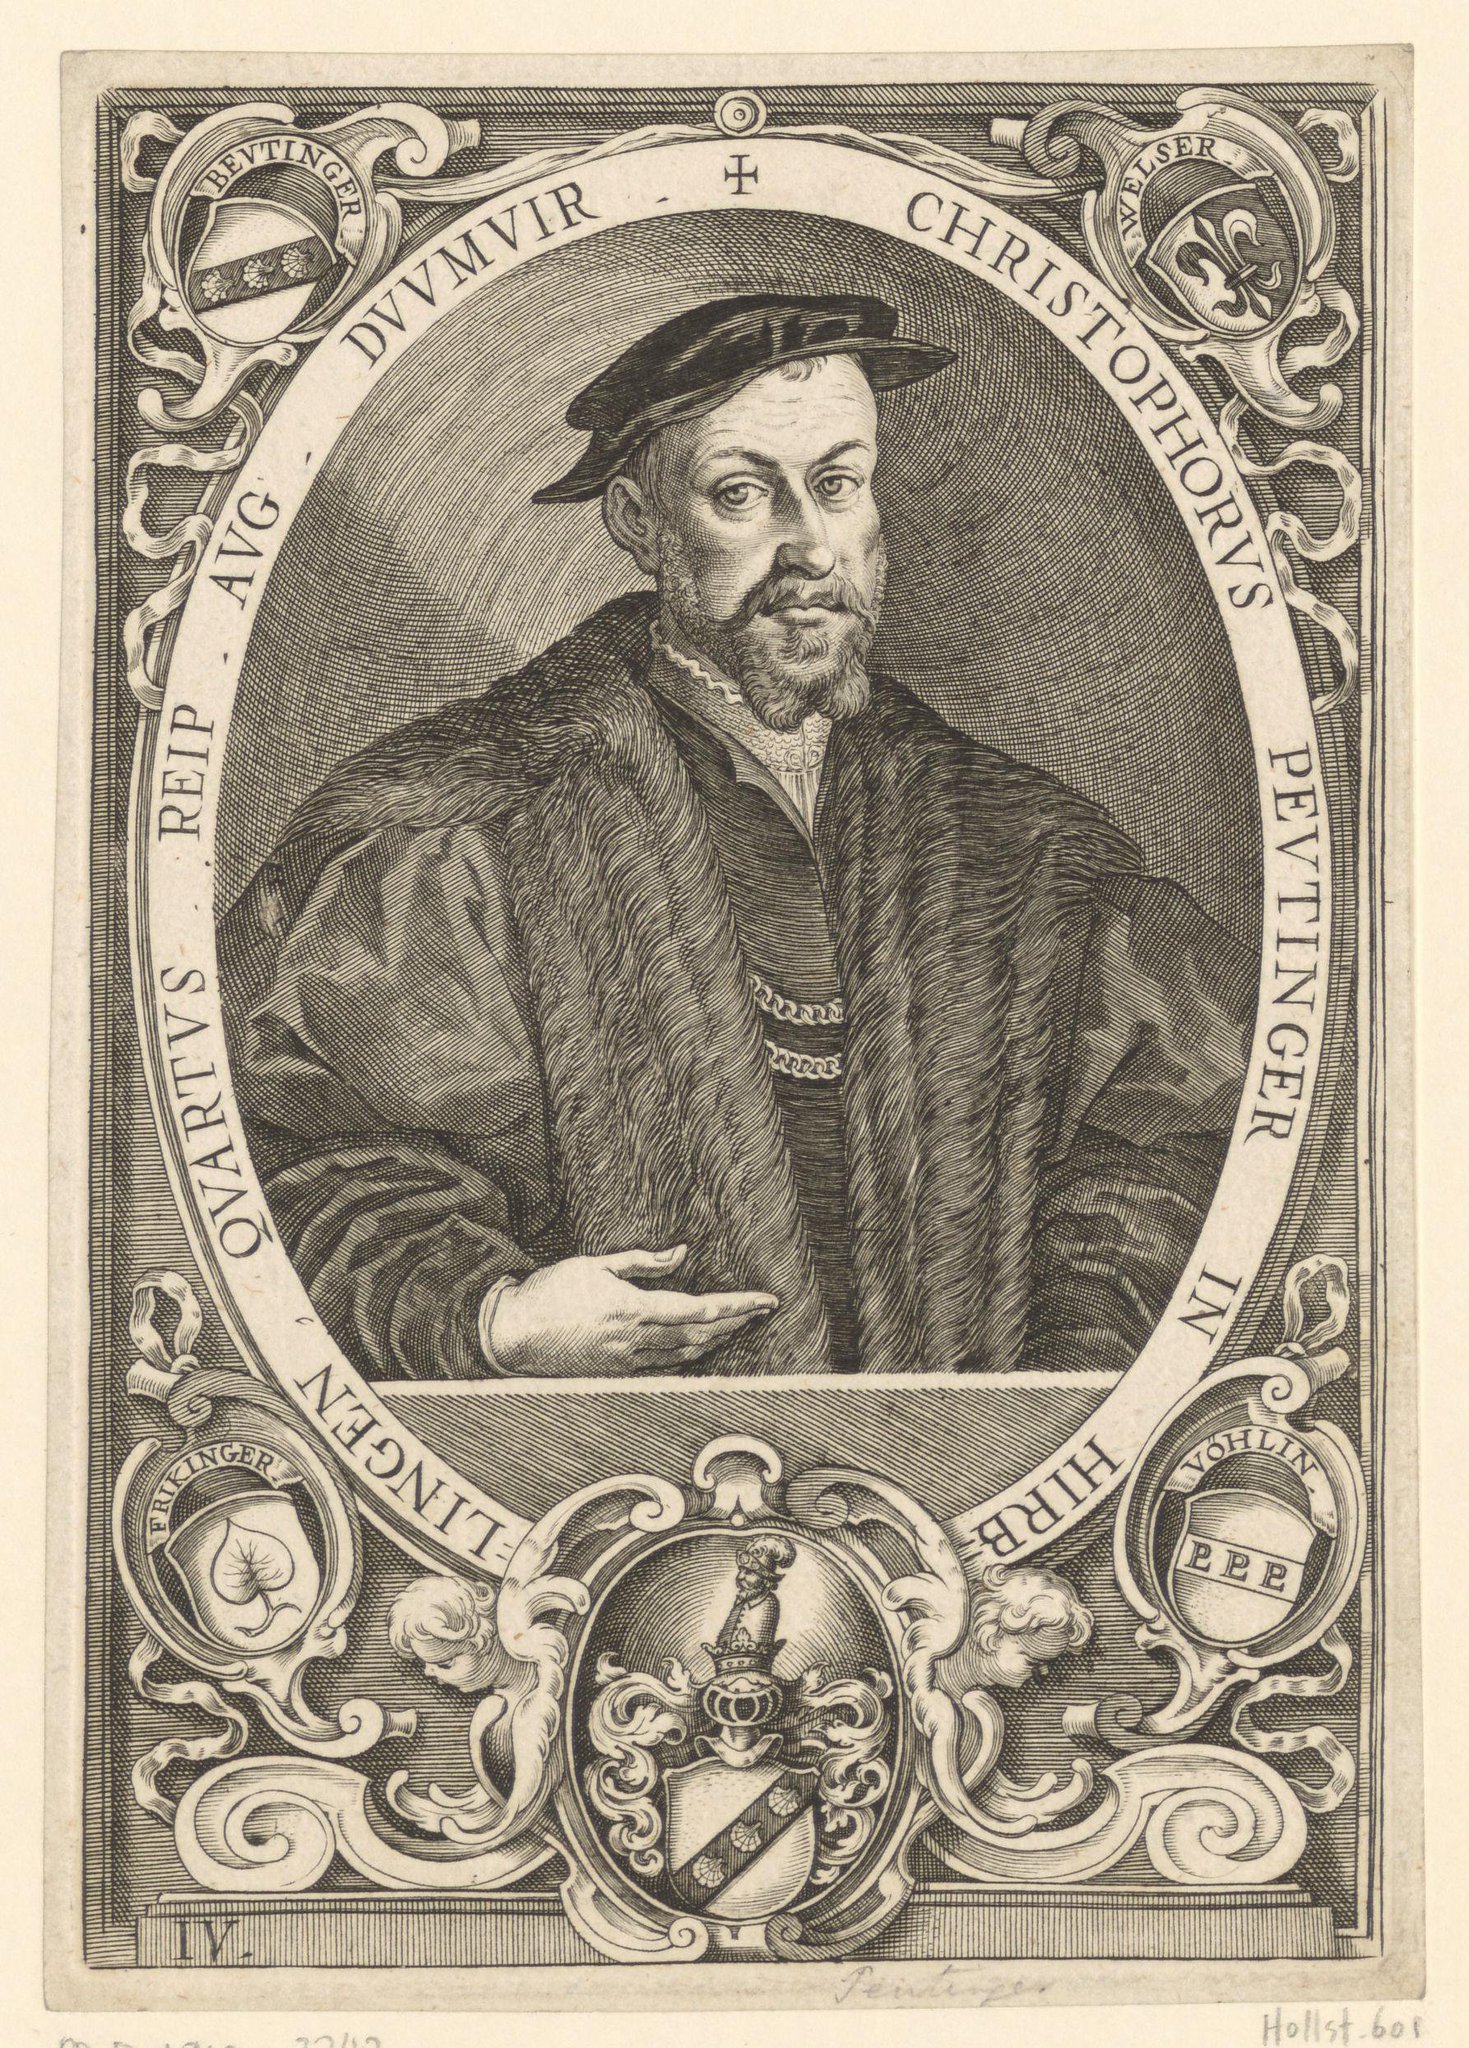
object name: book illustration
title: Portret van Christopher Peutinger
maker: lucas kilian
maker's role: draughtsman, print maker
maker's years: 1579-1637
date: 1615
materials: paper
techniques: engraving, etching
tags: mayor, coat of arms (as symbol of the state, etc.), mayor, burgomaster, historical persons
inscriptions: collector's mark: Lugt 2228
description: Deze prent is waarschijnlijk gebruikt voor: Kilian, Lucas. Imp. Caes. Caroli V.S.A. Decreto et auspiciis (...) formis expressi MDCXXIV. Augsburg: Lucas Kilian, 1624. In 1615 werd de eerste versie van dit boek door Lucas Kilian gepubliceerd onder de titel: Icones Omnium (...) Duumvirum, quotquot a prima Cardina Institutione usque ad praesentia Tempore Aerae Christ.M.DXCV. vixere. Hierin waren de titelpagina en de eerste veertien portretten door Lucas Kilian opgenomen. De versie uit 1624 bevat ook portretten door Wolfgang Kilian.